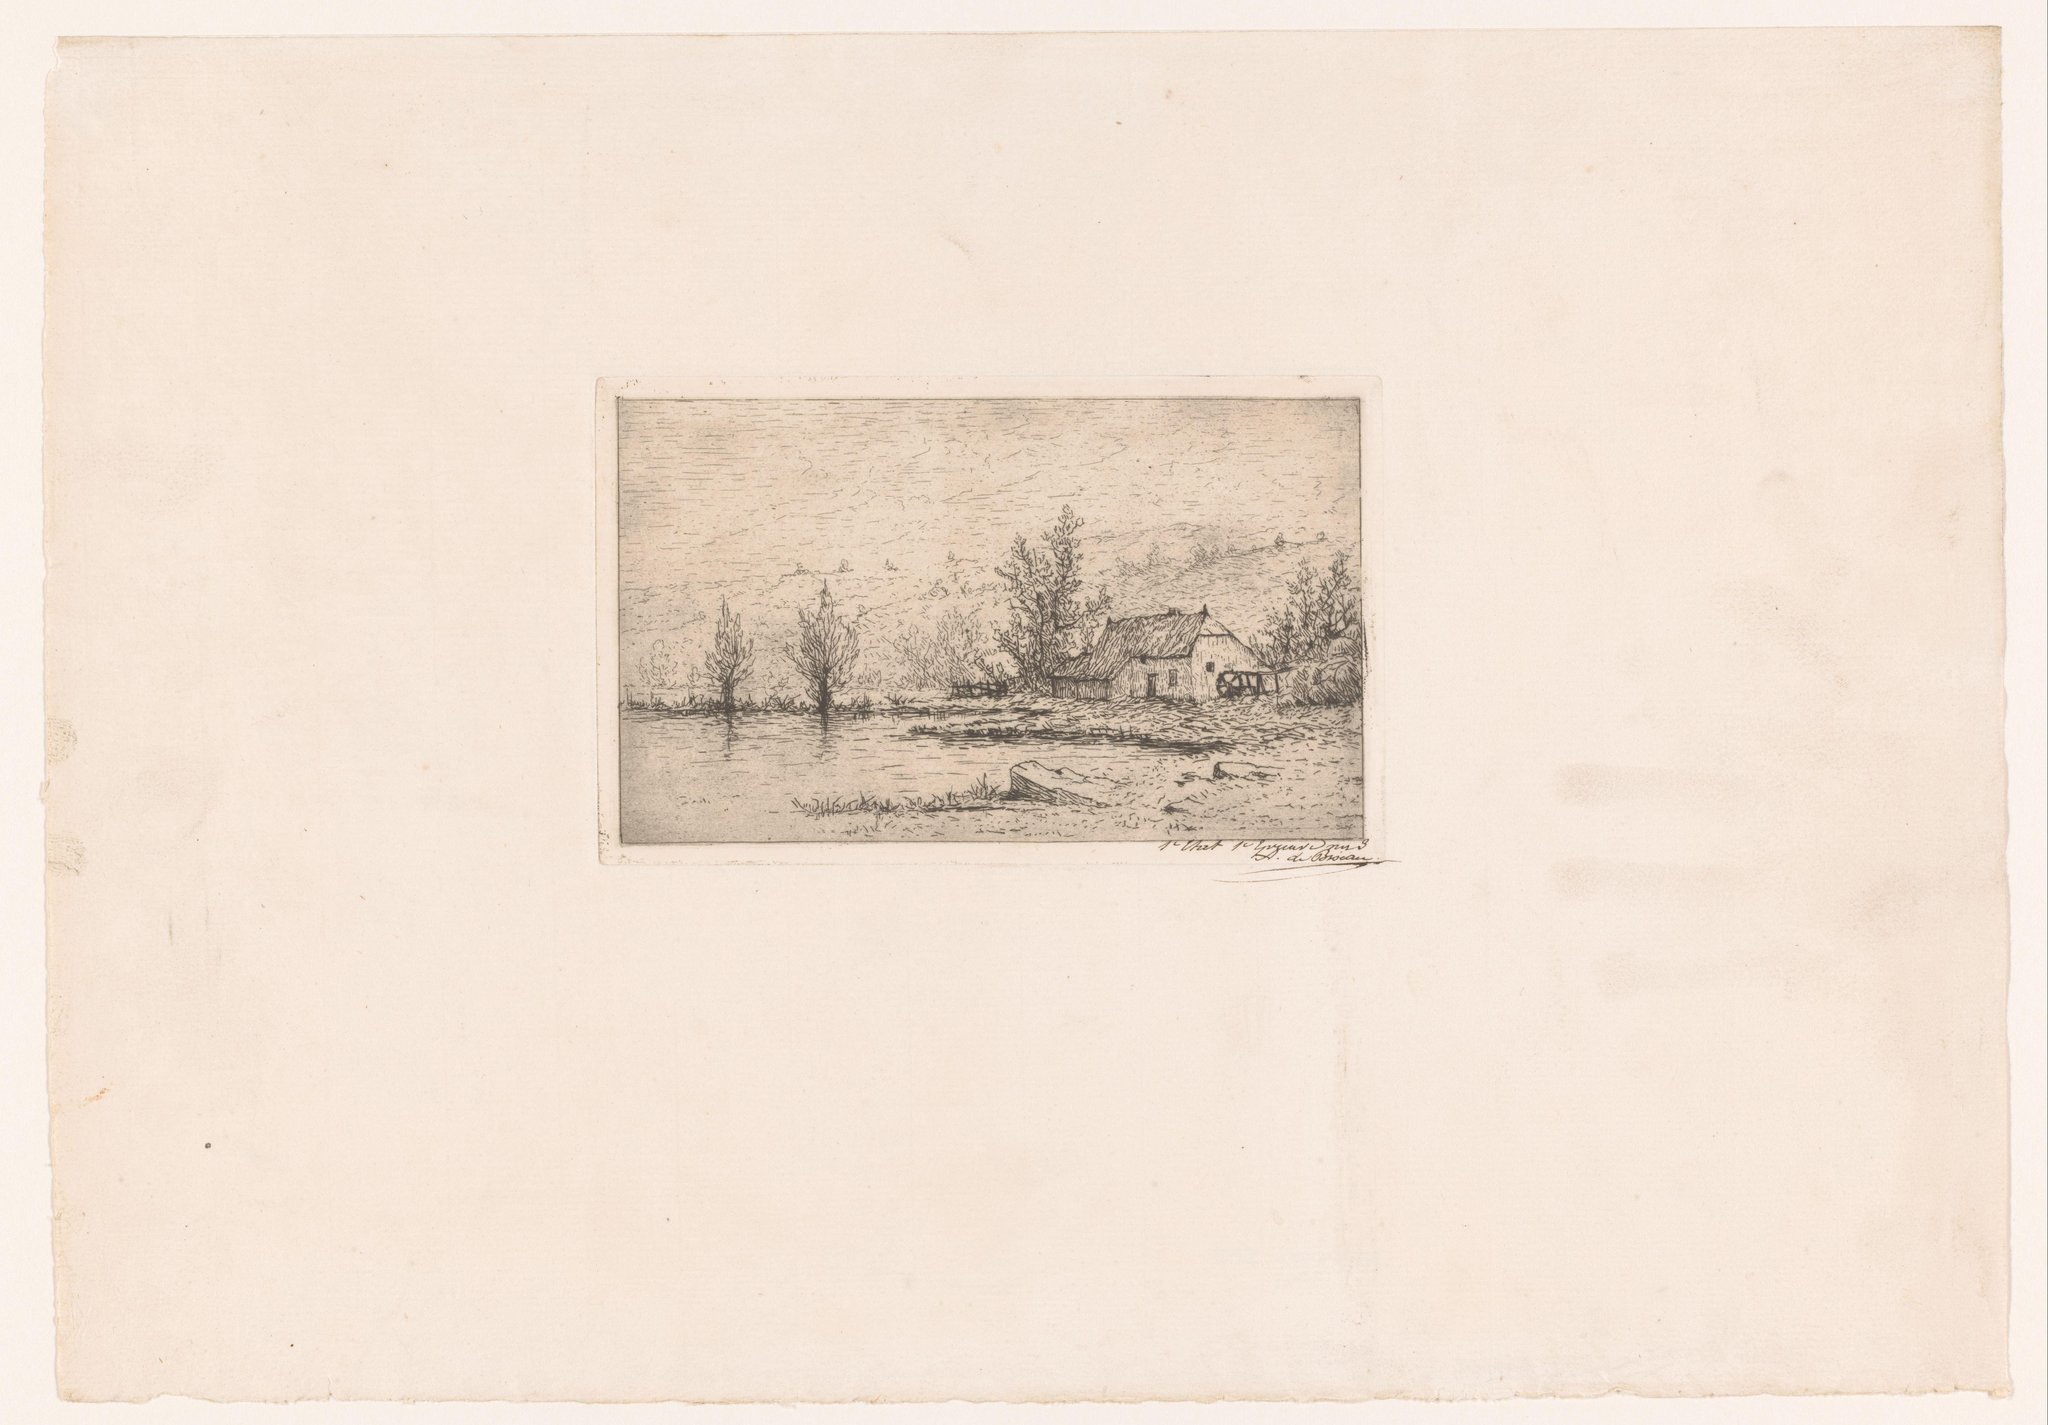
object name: print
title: Landschap met watermolen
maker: aristide de biseau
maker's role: print maker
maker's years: 1844-1883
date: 1854-1883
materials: paper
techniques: etching, intaglio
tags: watermill in landscape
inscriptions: annotation: ‘1e Etat 1e Epreuve nr 3’, collector's mark: Lugt 2228